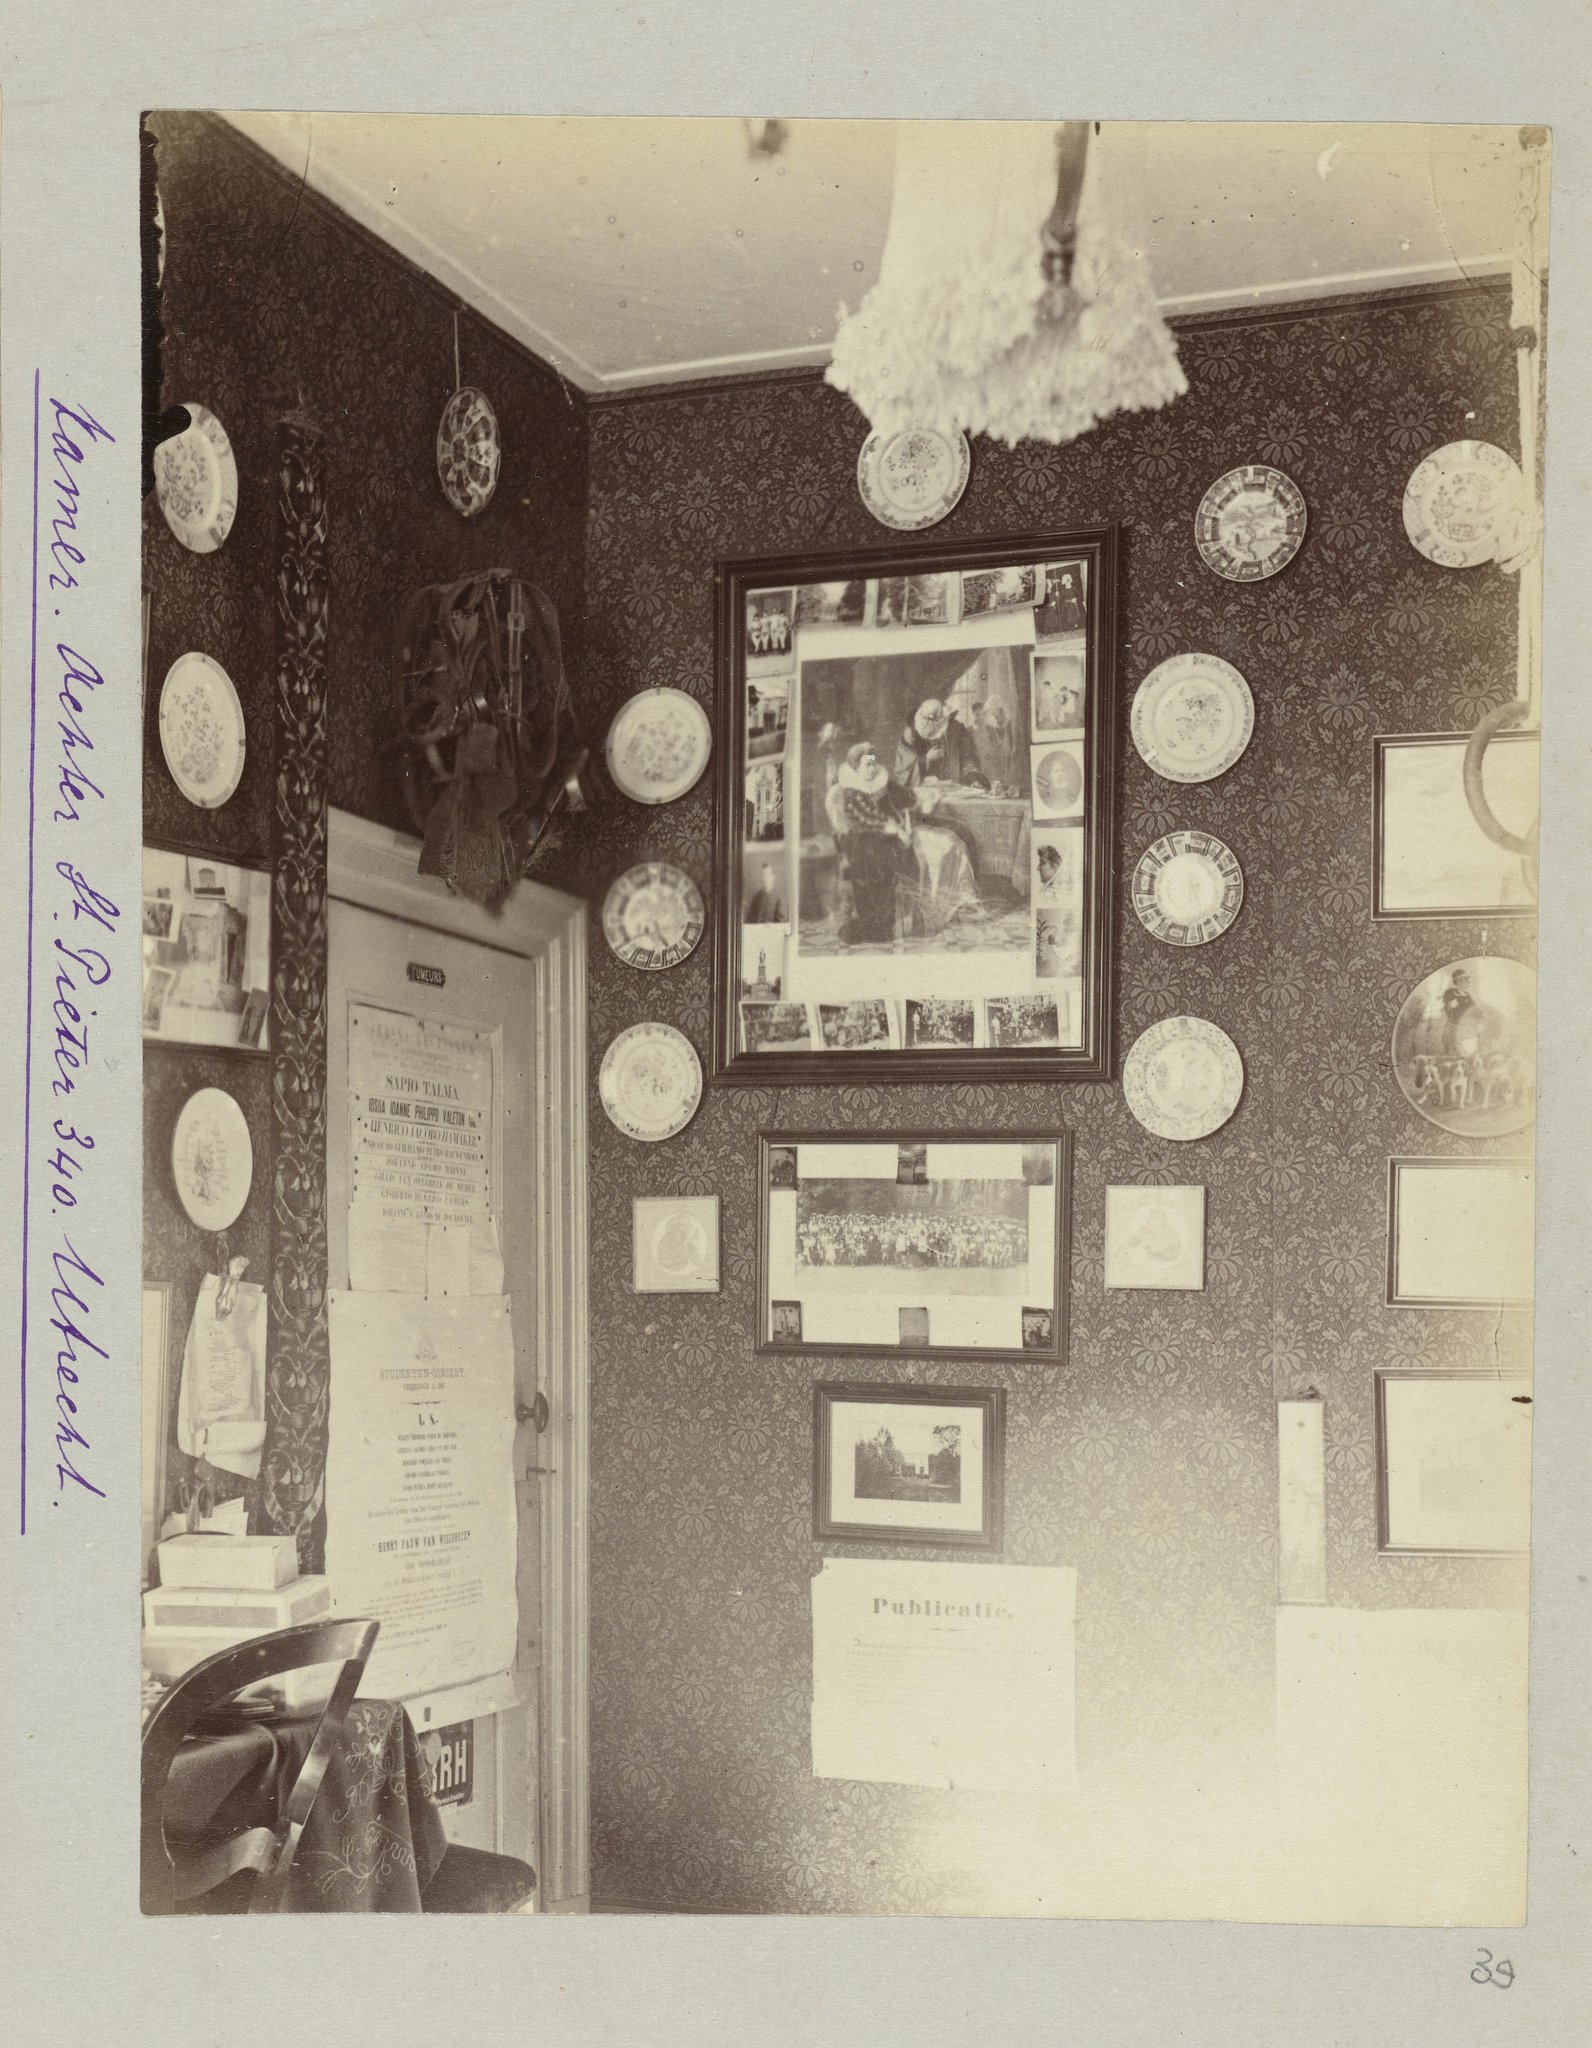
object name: photograph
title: Student Rooms of Pauw van Wieldrecht’s Friends in Utrecht and The Hague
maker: henry pauw van wieldrecht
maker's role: fotograaf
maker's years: 1863-1912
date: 1889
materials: paper, photographic support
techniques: albumen print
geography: netherlands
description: Pauw van Wieldrecht sometimes took part in photography exhibitions. The Rijksmuseum owns around four hundred of his photographs and various albums. The amount of work preserved is more than that of any other amateur of the late 19th century.